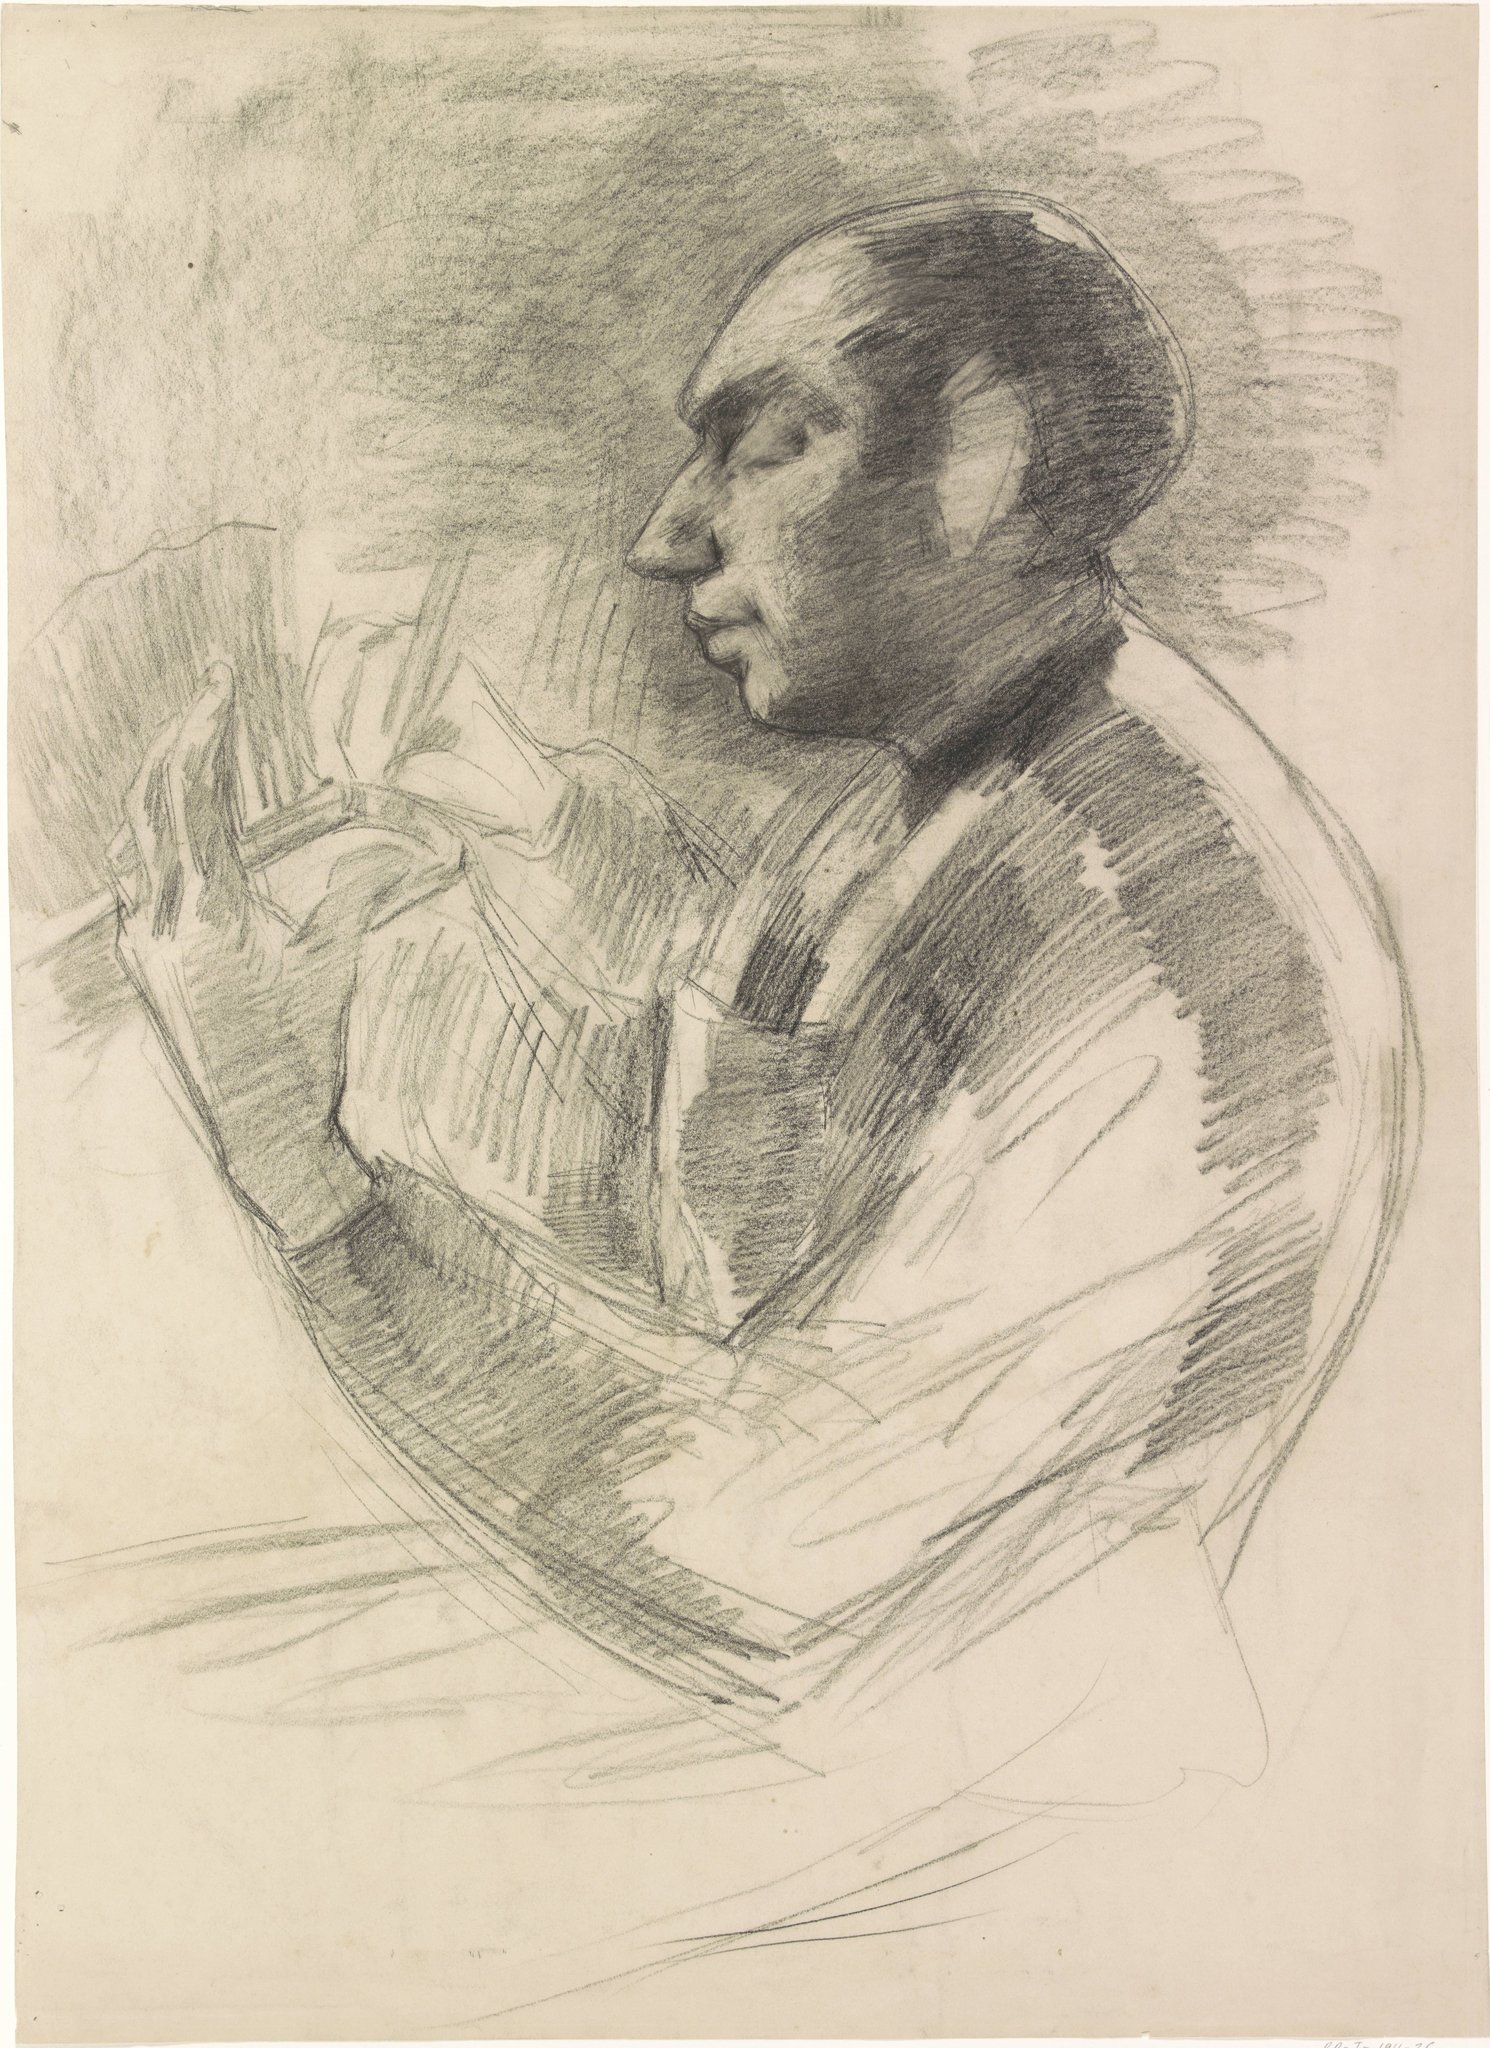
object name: drawing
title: Blinde borstelmaker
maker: anthon gerhard alexander van rappard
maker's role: draughtsman, print maker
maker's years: 1858-1892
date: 1868-1892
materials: charcoal, paper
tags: (household) utensils and implements (with name), handicrafts ~ other animal material (+ men (labourers)), blind, blindness